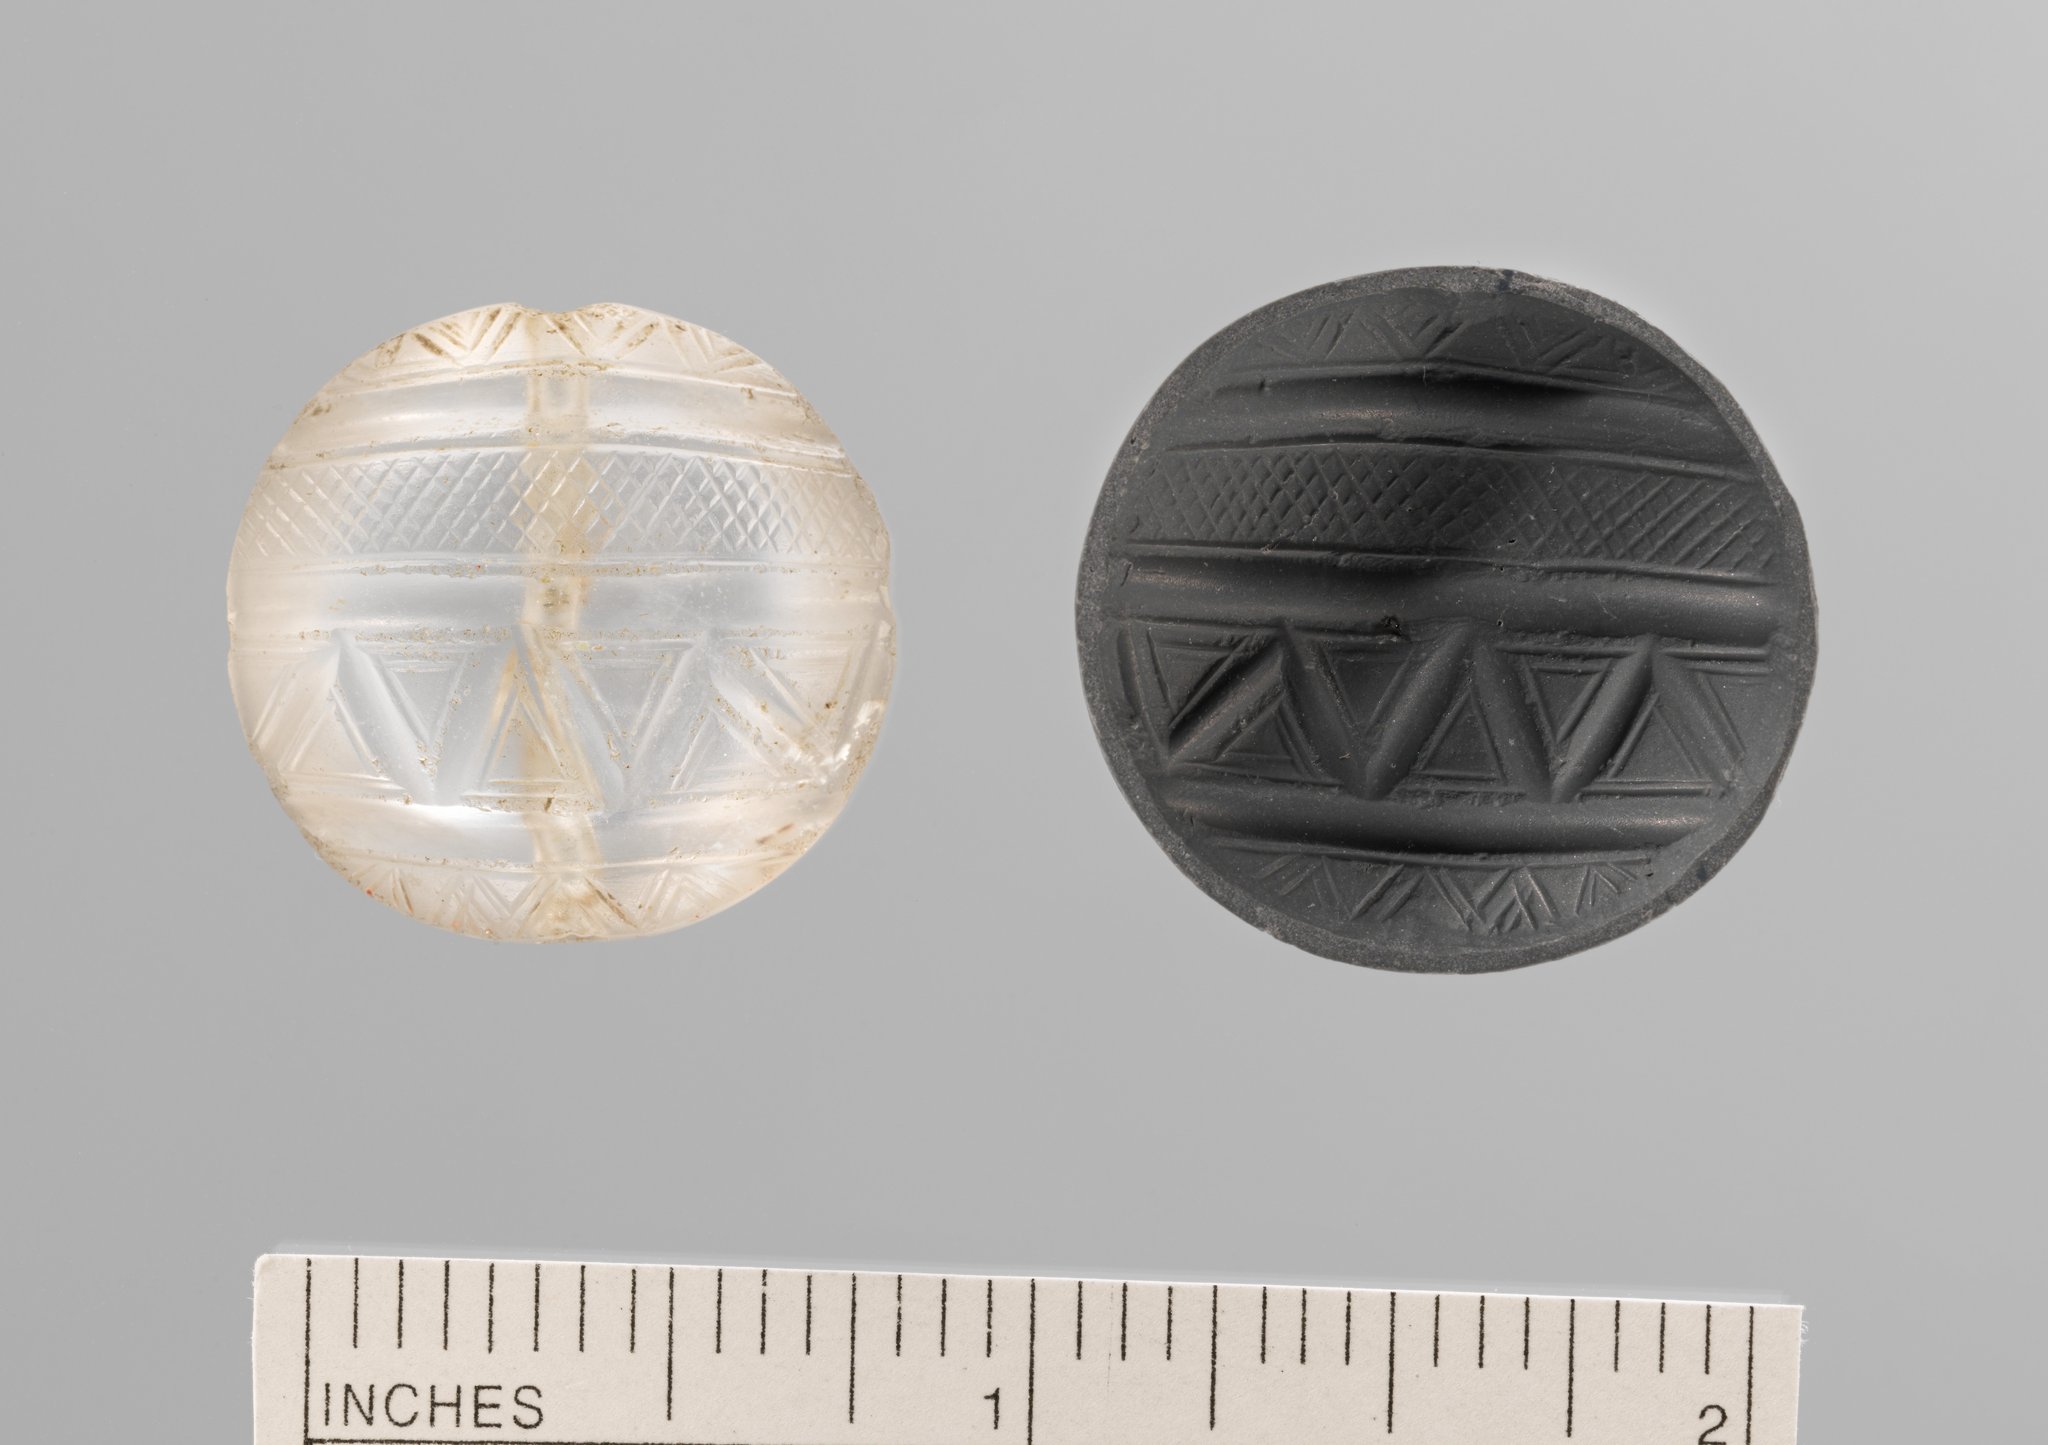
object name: seal, lentoid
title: Rock crystal lentoid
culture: minoan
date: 1700-1600 BCE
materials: quartz